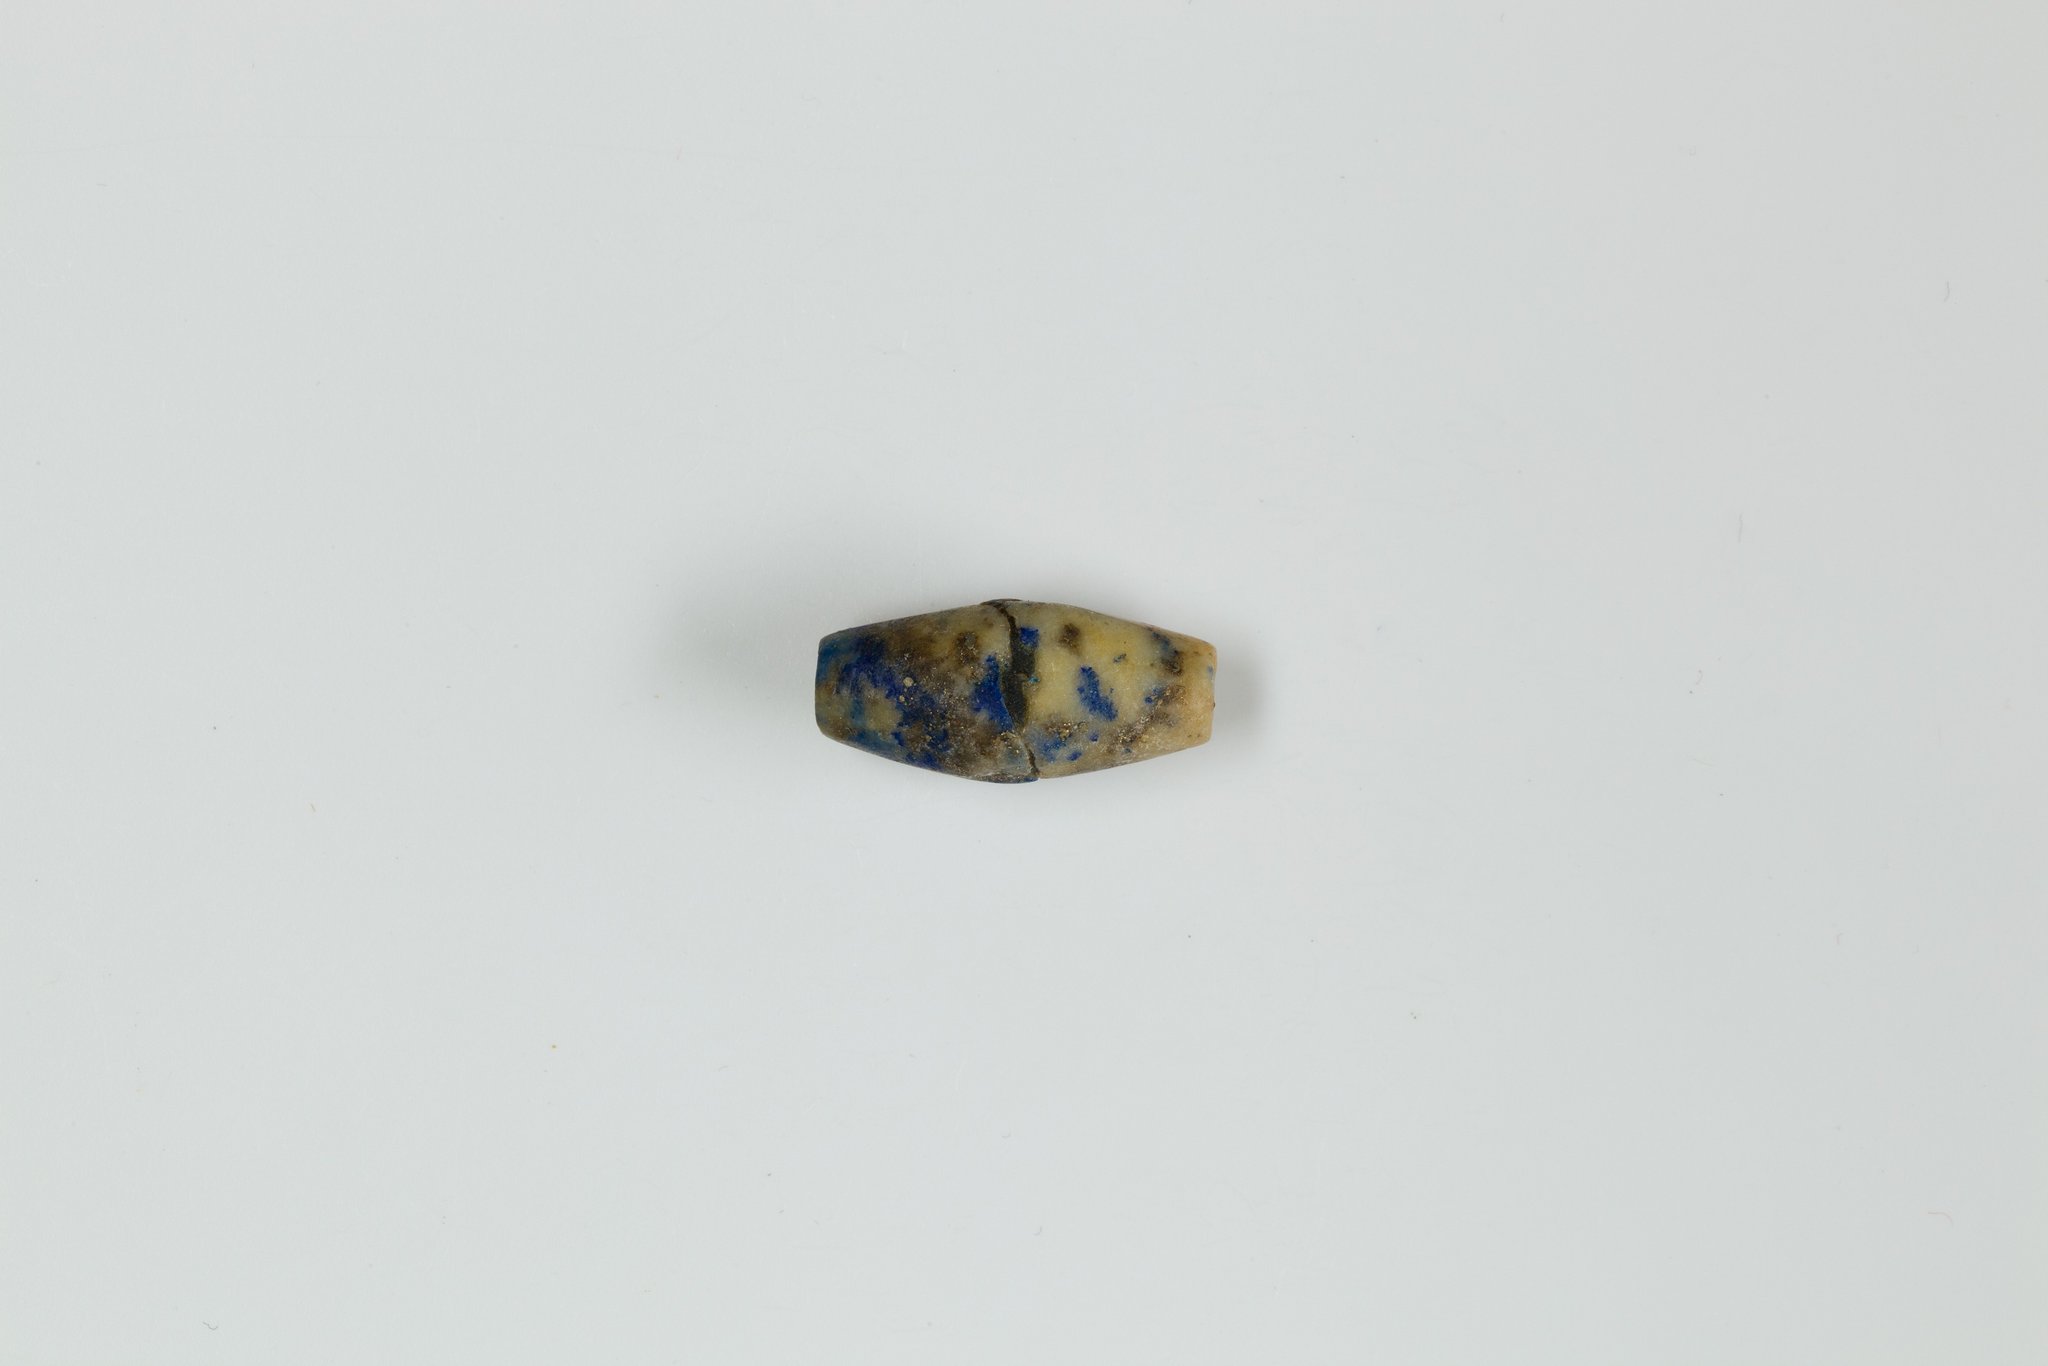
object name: bead, barrel, nesenaset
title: Barrel bead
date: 1070-945 BCE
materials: lapis lazuli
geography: egypt